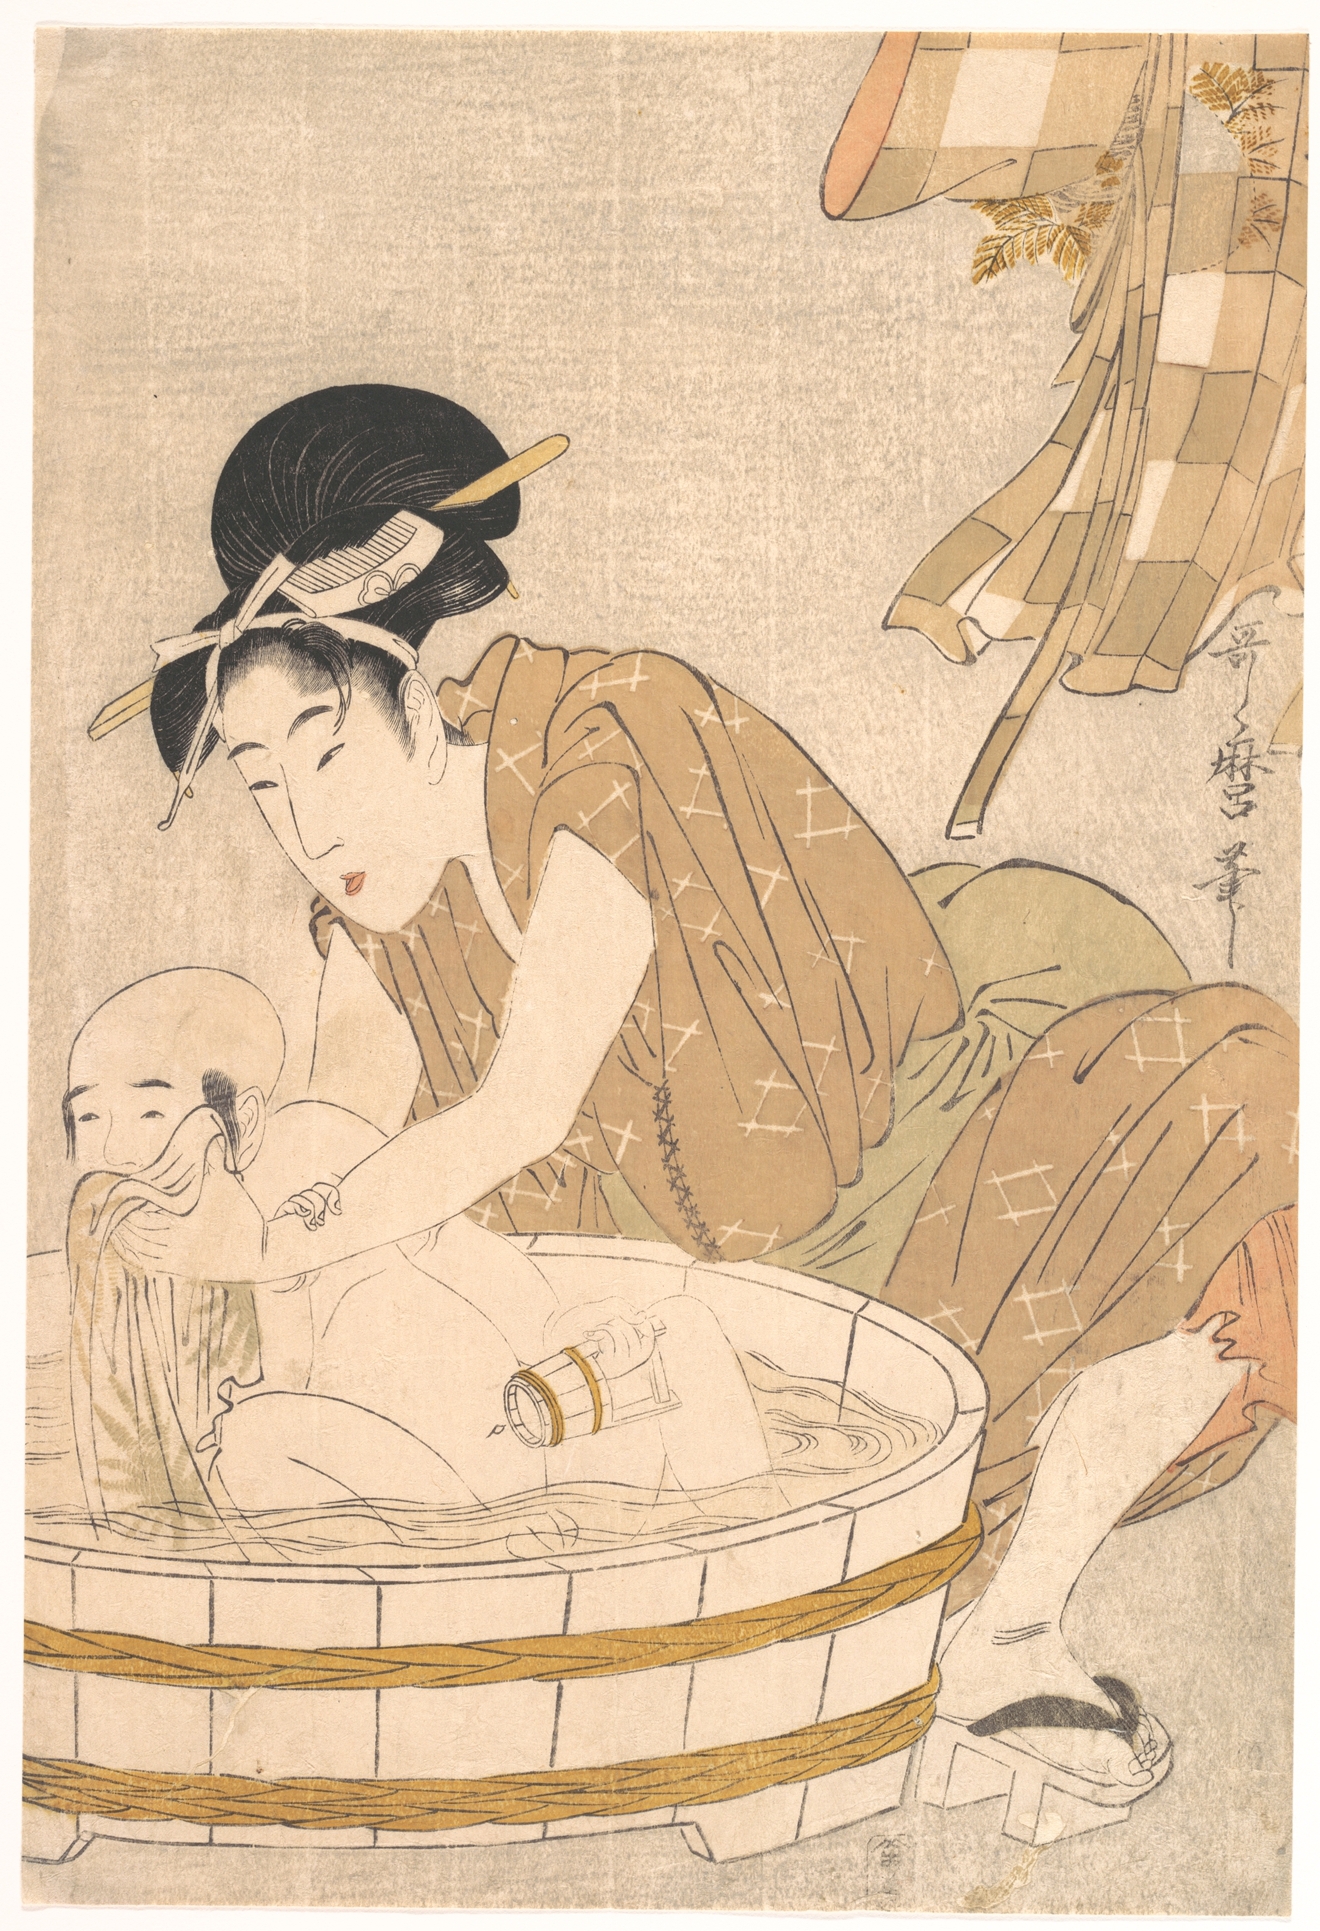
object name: print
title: Bathtime (Gyōzui)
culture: japanese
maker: kitagawa utamaro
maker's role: artist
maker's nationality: japanese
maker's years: 1754-1806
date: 1801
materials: ink, paper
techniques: woodblock print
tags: children,mothers,women,bathing